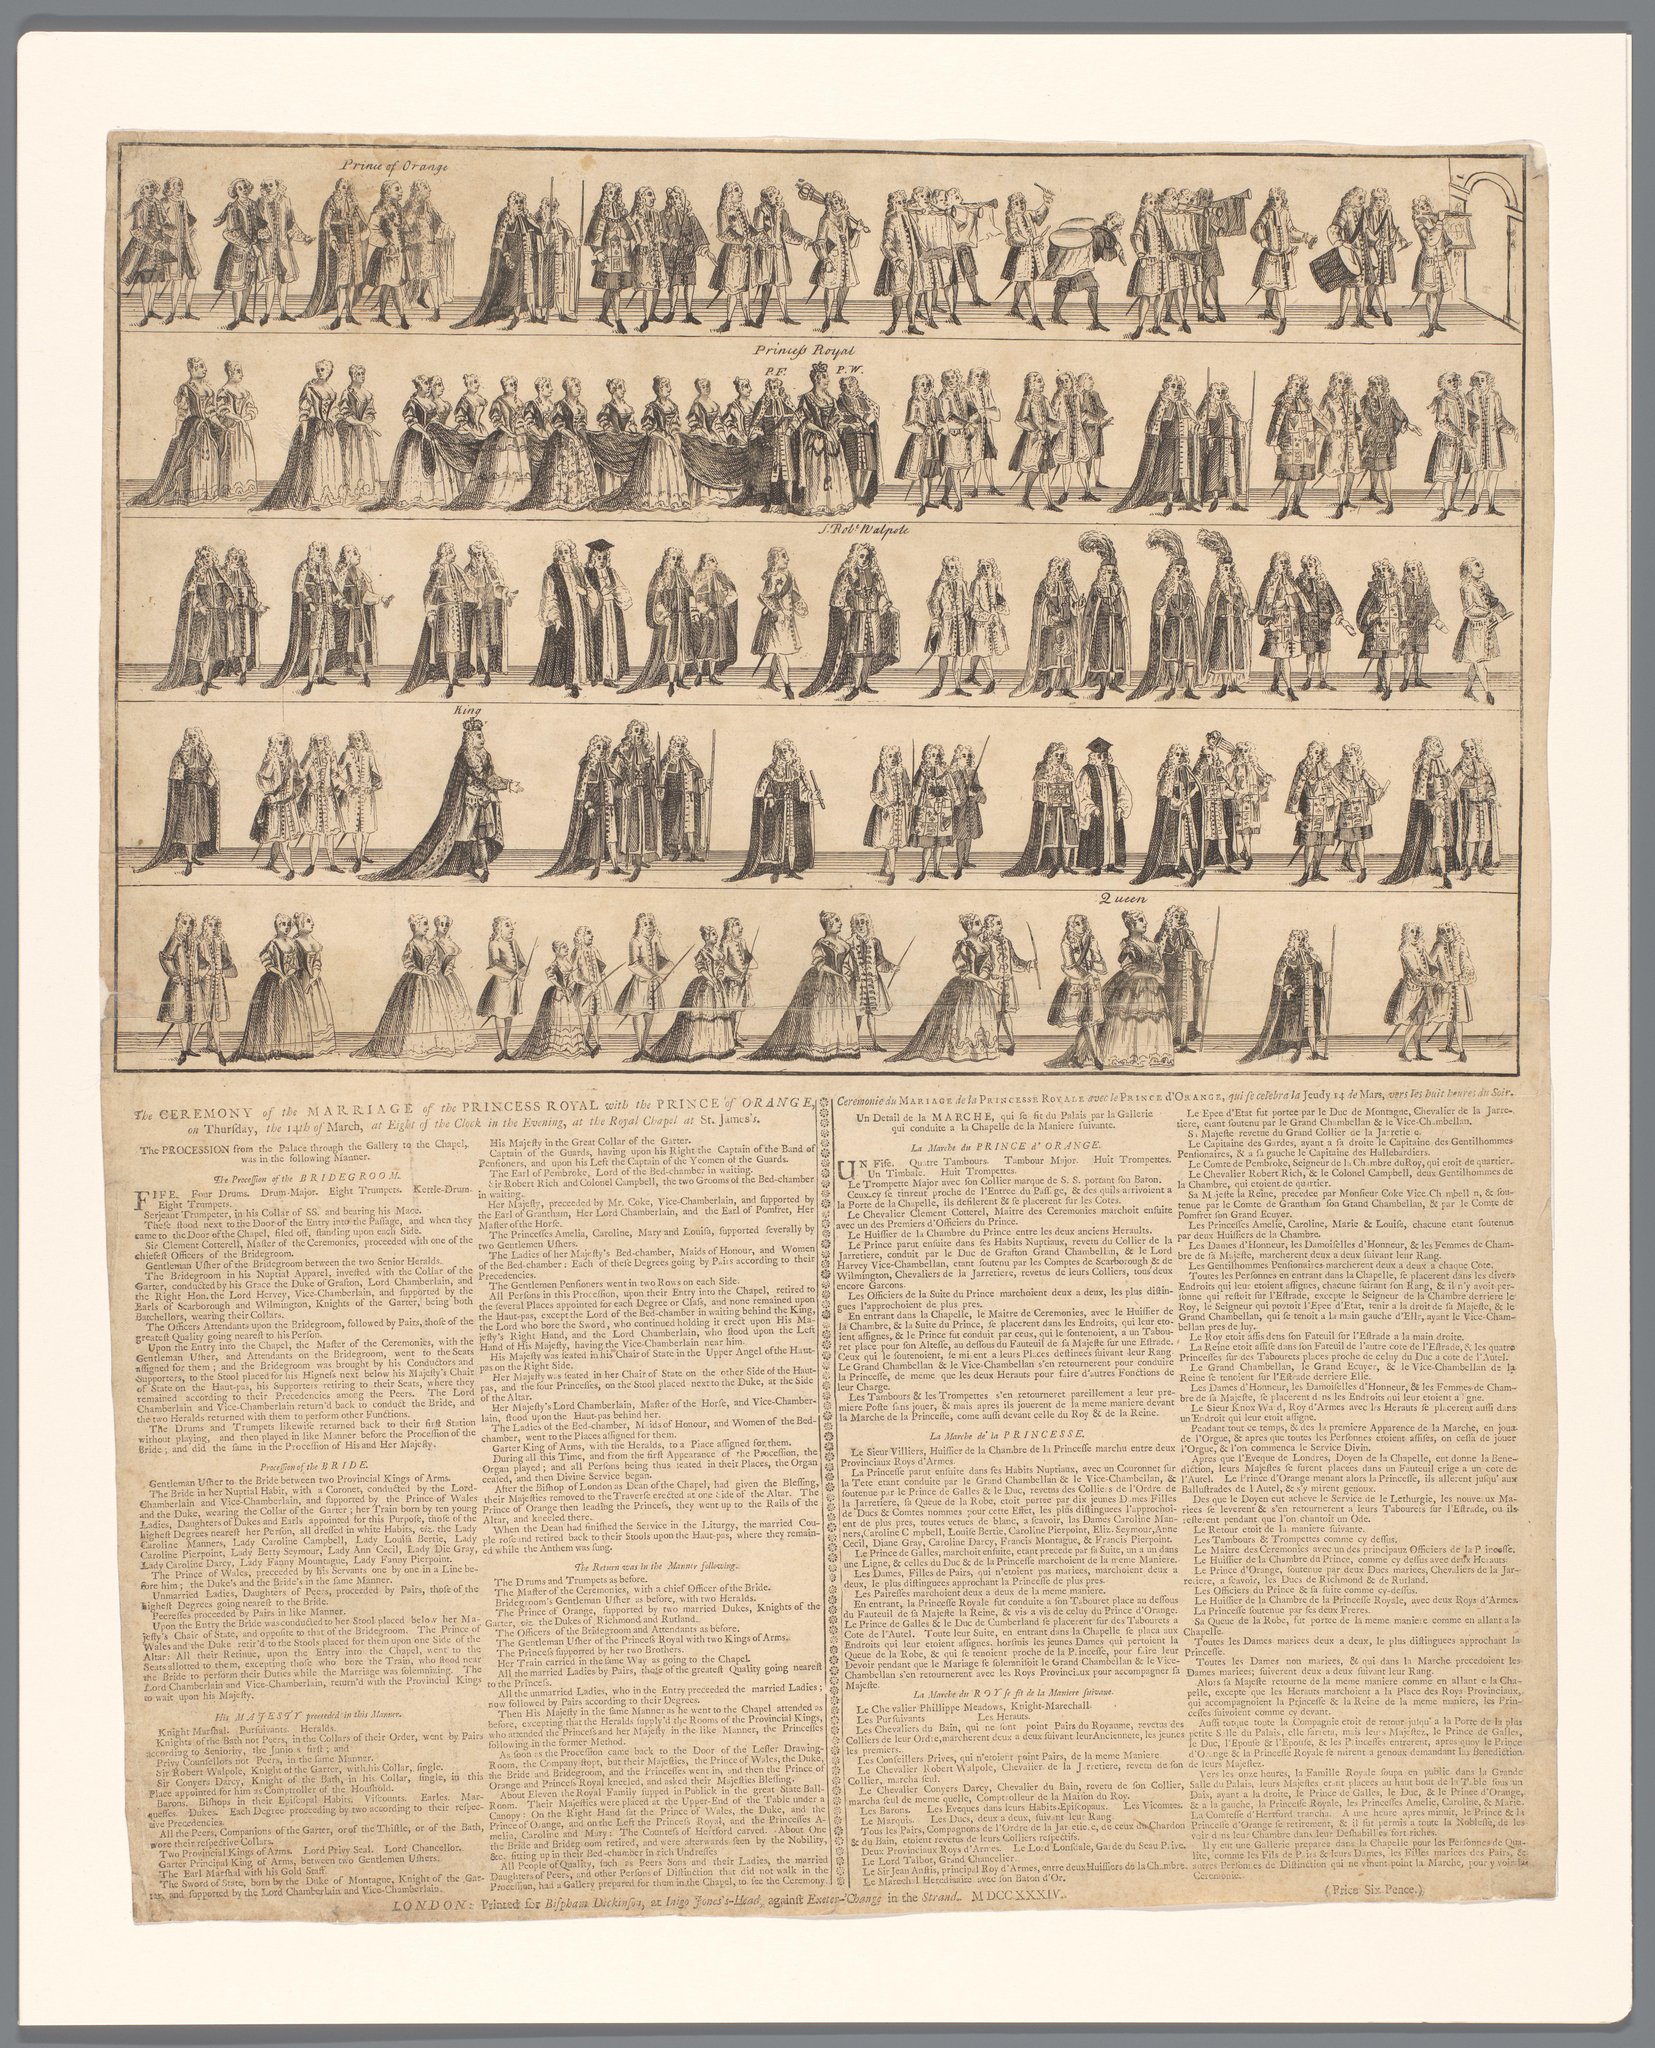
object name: print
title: The Ceremony of the Marriage of the Princess Royal with the Prince of Orange, on Thursday, the 14th of March, at Eight of the Clock in the Evening, at the Royal Chapel at St. James's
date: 1734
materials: paper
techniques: etching, letterpress printing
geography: london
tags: willem iv (prins van oranje-nassau), anna van hannover, civil marriage ceremony, marriage ~ protestant service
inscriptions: collector's mark: Lugt 2228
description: Processie ter gelegenheid van het huwelijk van stadhouder Willem IV en Anna van Hannover, 25 maart 1734, in de Chapel Royal in St. James's Palace. De processie afgebeeld in vijf rijen onder elkaar. Daaronder op hetzelfde blad de gedrukte tekst met de beschrijving van de gelegenheid in twee kolommen in het Engels en twee kolommen in het Frans.